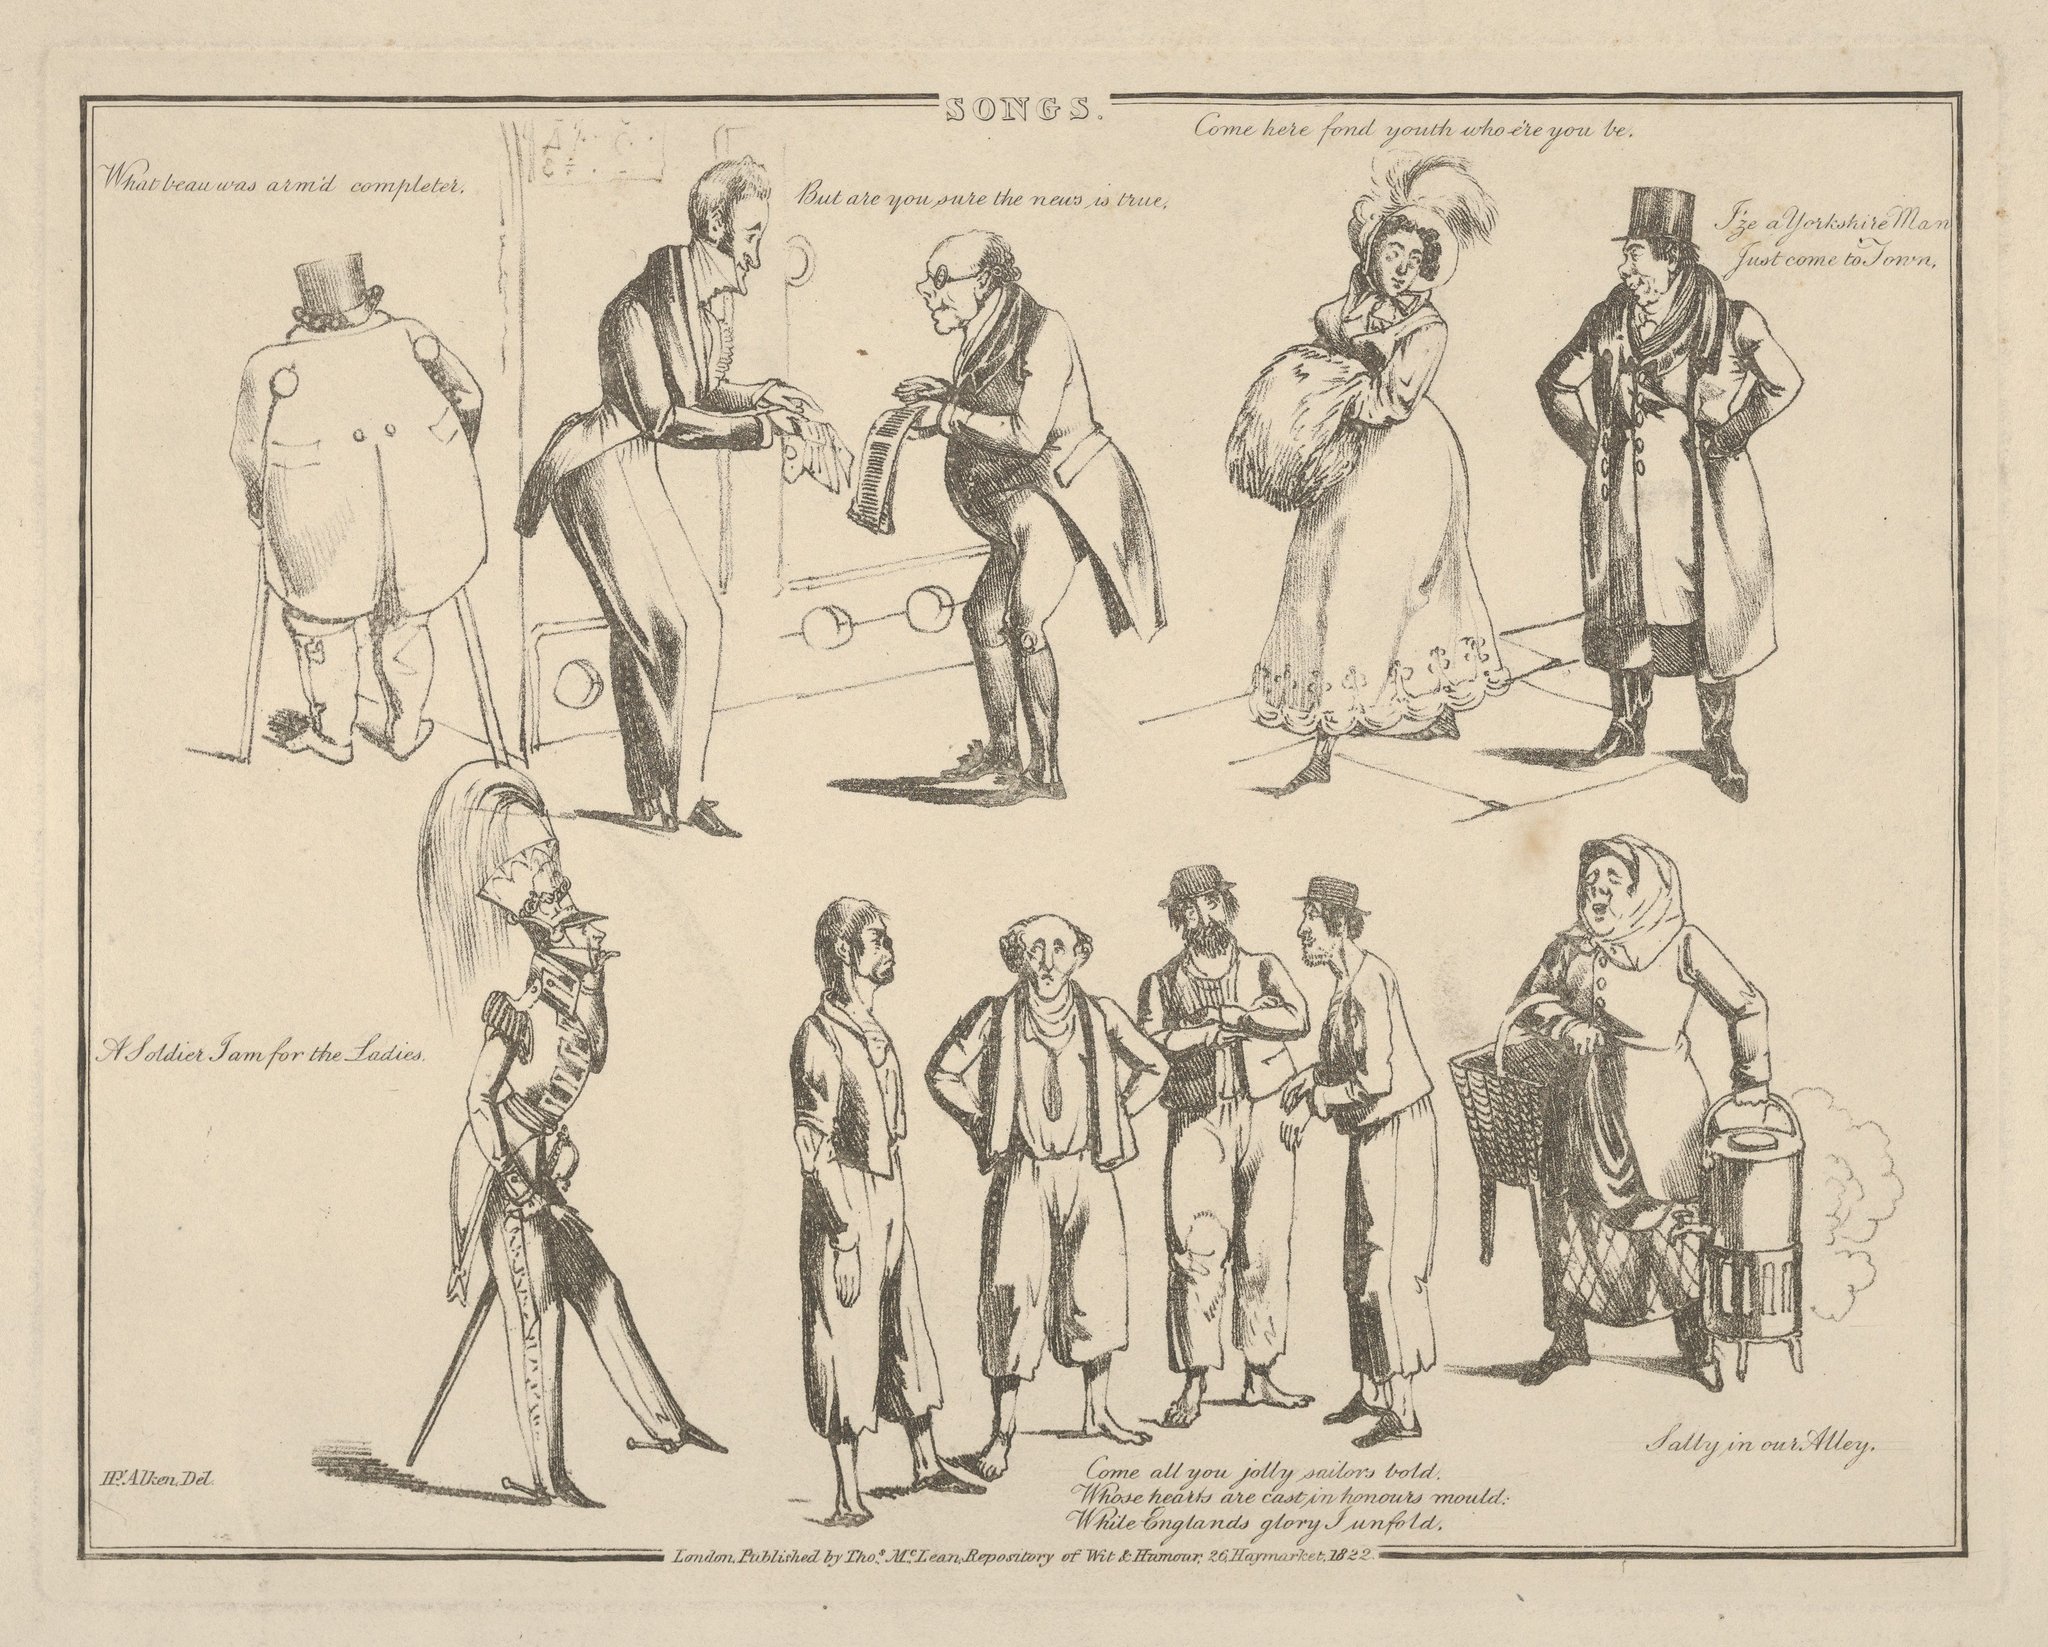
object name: print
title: Songs: "What beau was arm'd completer..."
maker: henry alken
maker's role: artist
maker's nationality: british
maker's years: 1785-1851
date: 1822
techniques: etching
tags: men,women